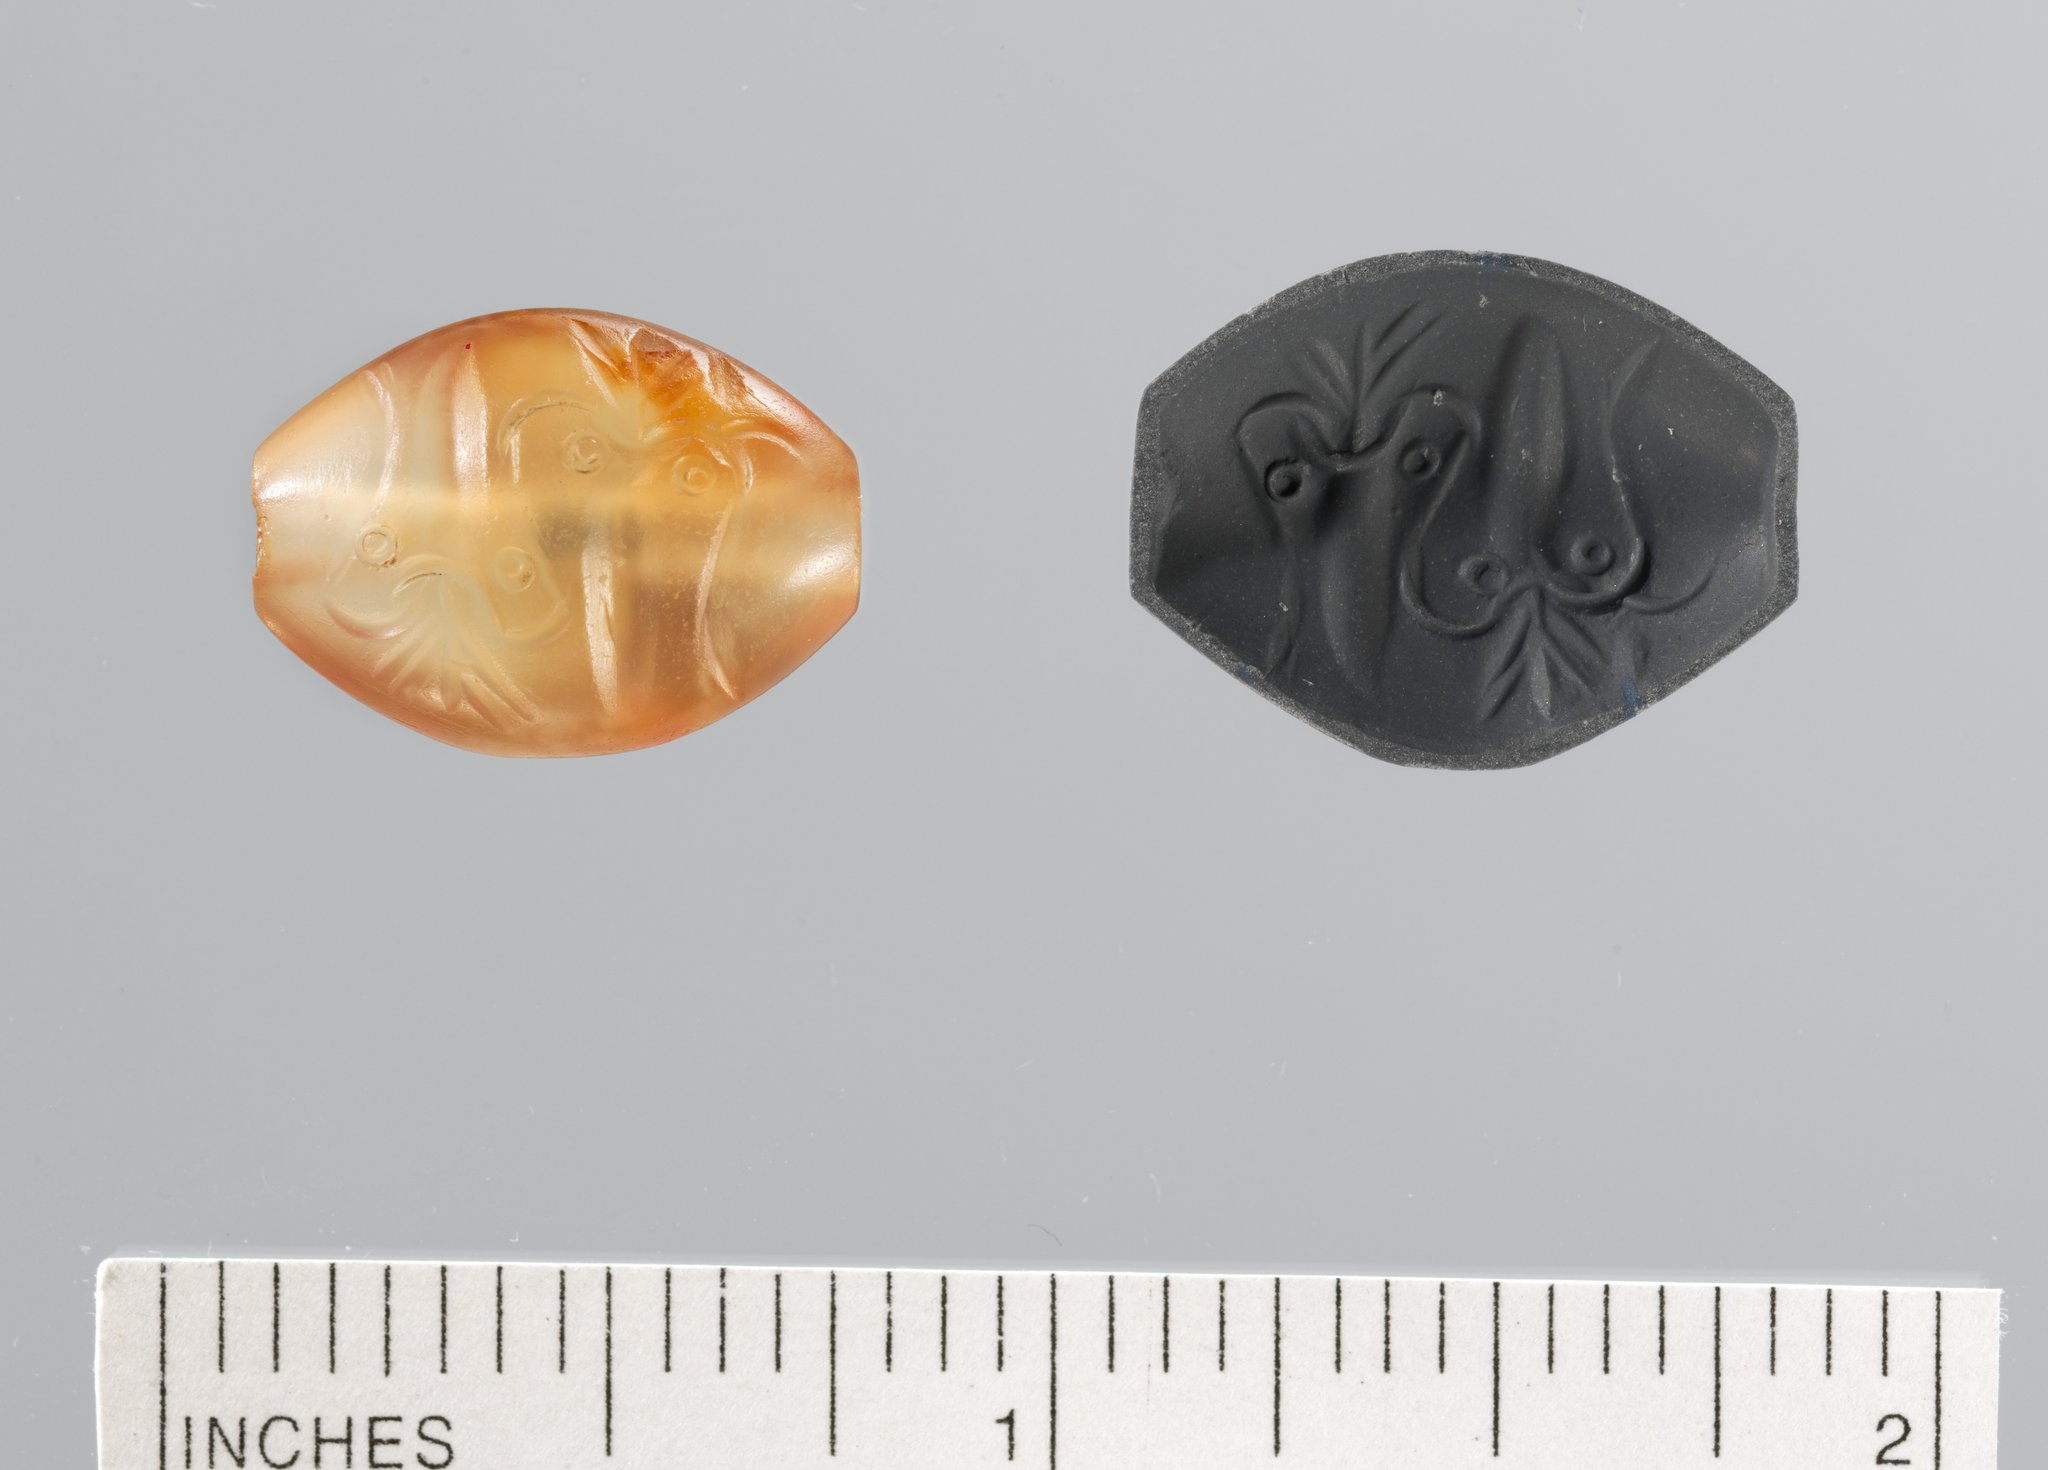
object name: seal, amygdaloid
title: Chalcedony Amygdaloid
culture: minoan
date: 1650-1500 BCE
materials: stone